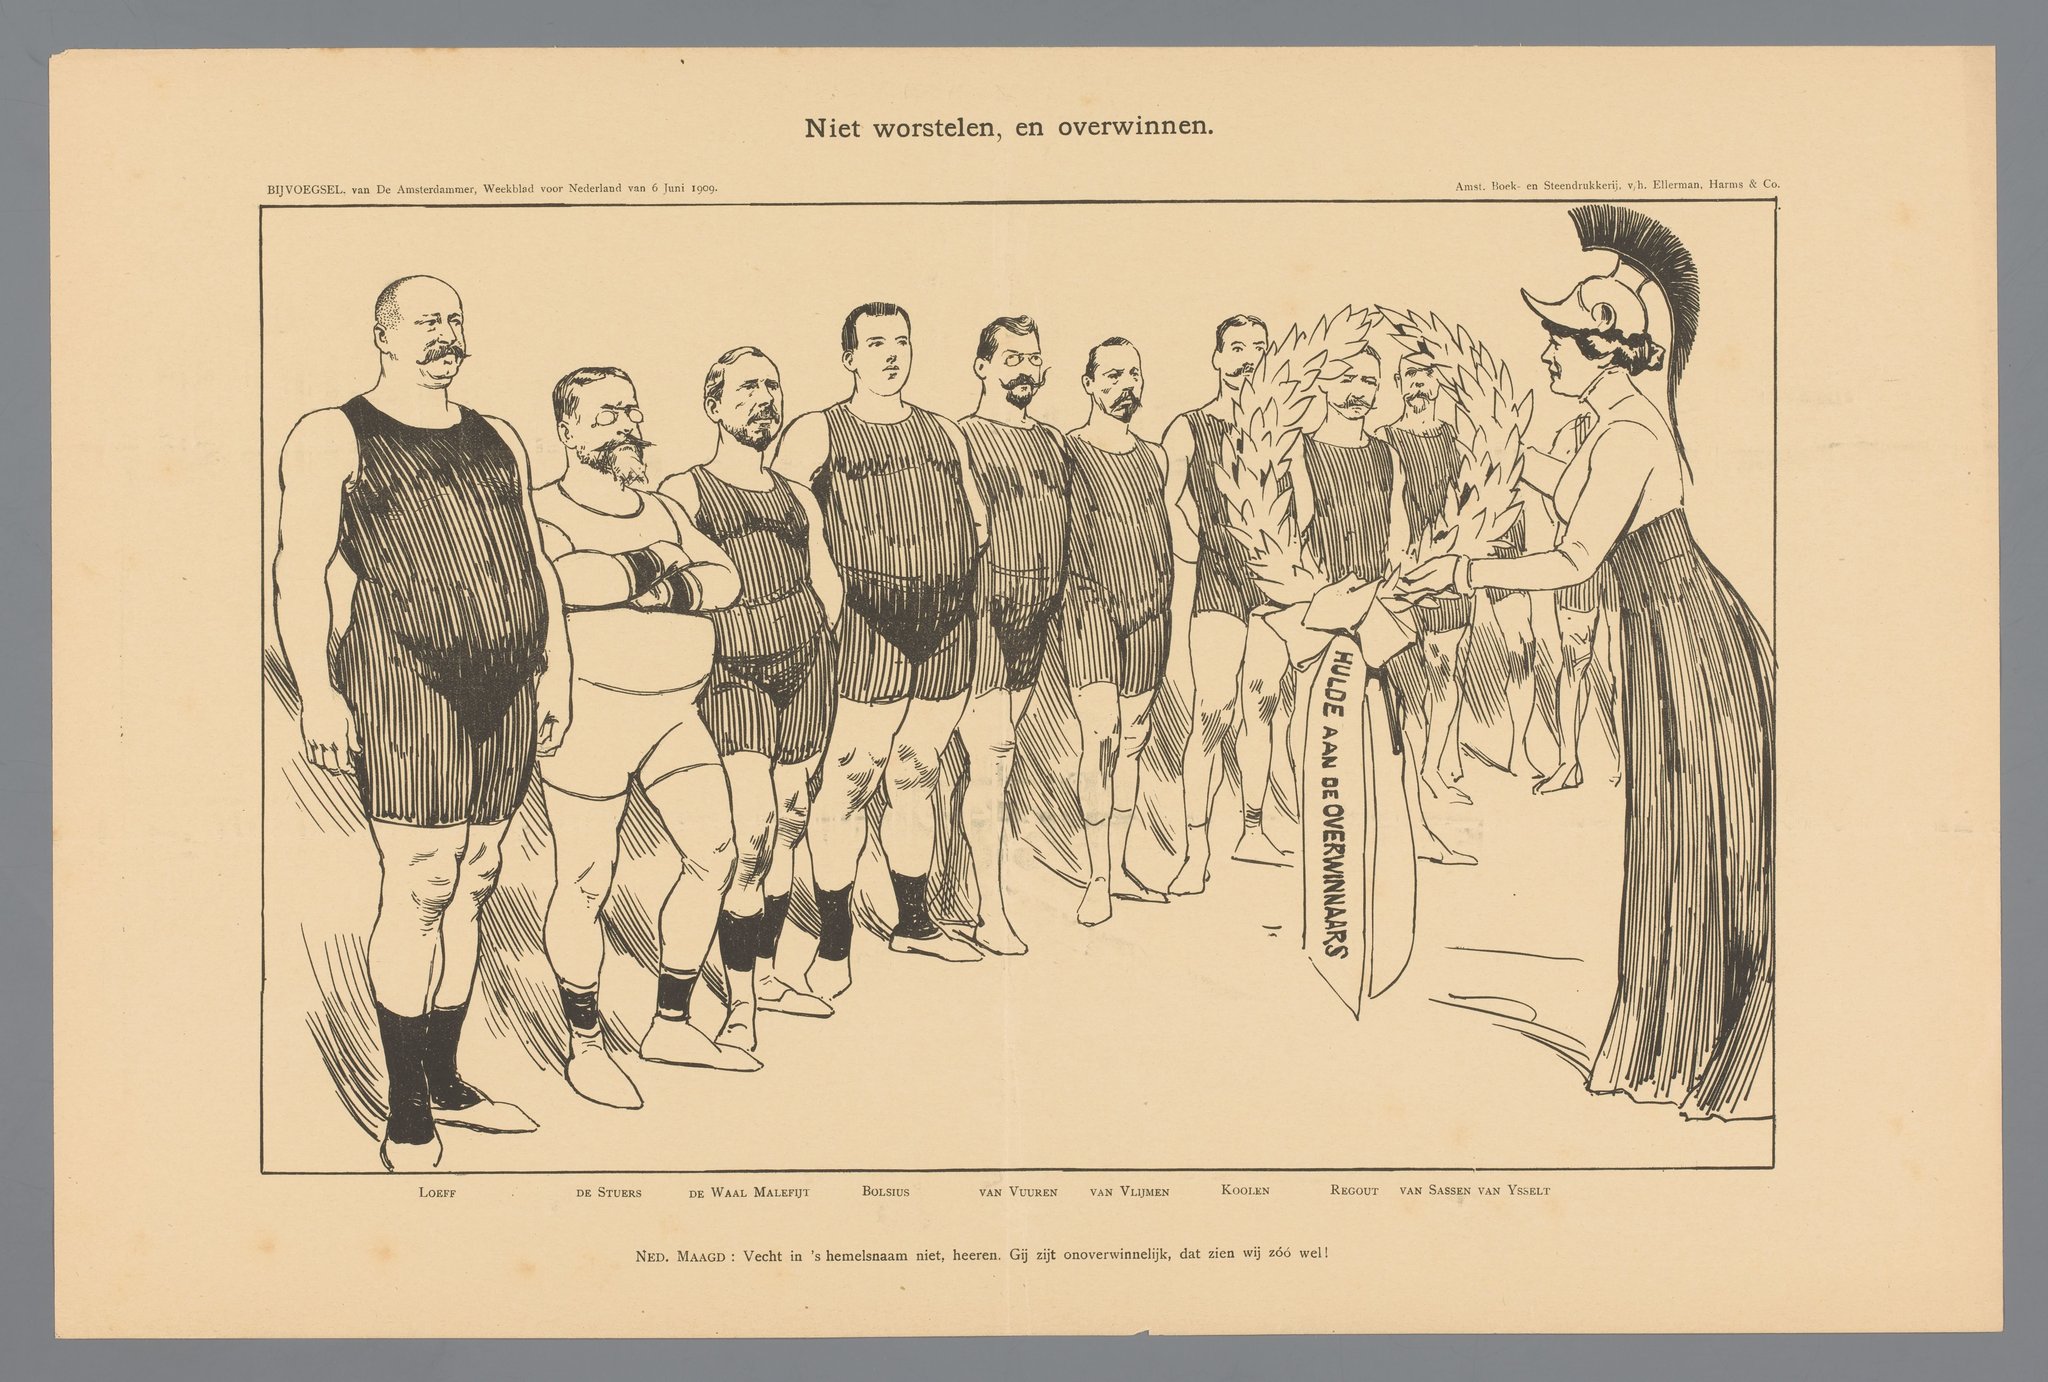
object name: cartoon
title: Niet worstelen, en overwinnen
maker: johan braakensiek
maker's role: draughtsman, print maker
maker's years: 1858-1940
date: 1909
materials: paper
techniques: lithograph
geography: amsterdam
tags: maastricht, the hague, print maker, jonkheer victor eugène louis de stuers, politician, historical persons, wrestling (sport), personifications of countries, nations, states, districts, etc. (+ nation; national), political caricatures and satires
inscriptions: date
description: Prent uit het bijvoegsel van: De Amsterdammer. Weekblad voor Nederland, 6 juni 1909.